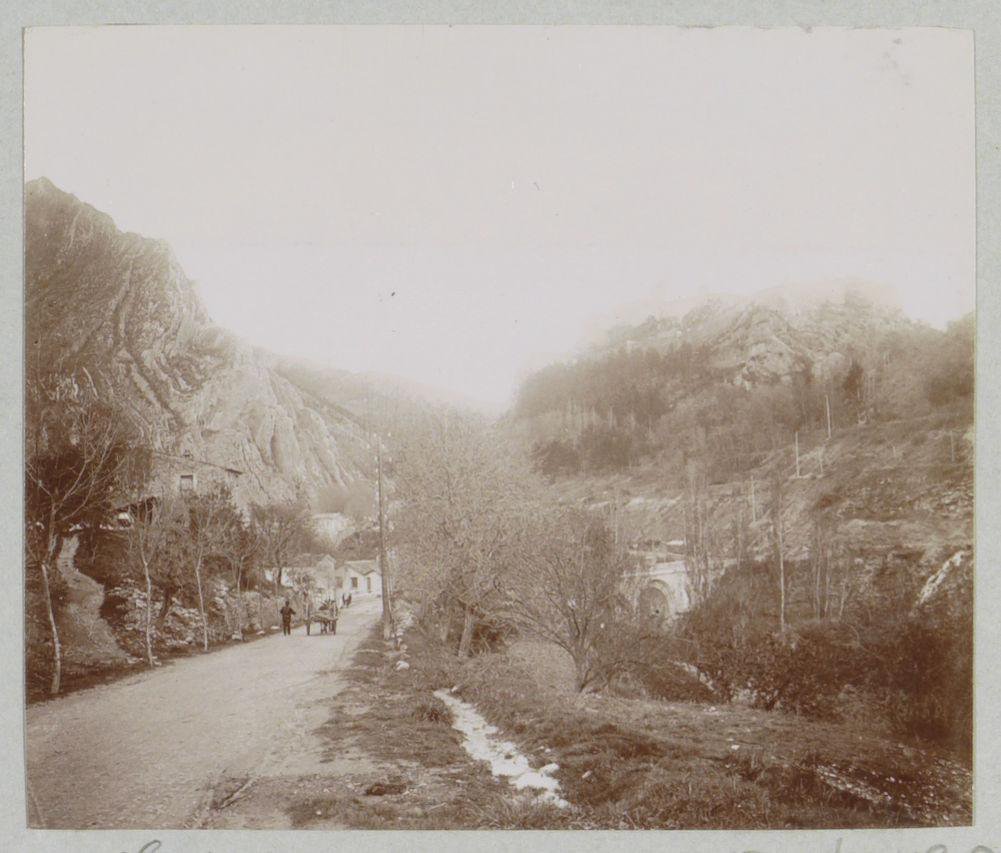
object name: photograph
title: Weg door een kloof bij Sisteron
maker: delizy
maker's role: manufacturer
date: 1903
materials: paper, photographic support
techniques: gelatin silver print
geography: sisteron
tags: ravine, chasm, abyss, canyon, road, path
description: Onderdeel van Fotoalbum van een Franse amateurfotograaf met opnames van uitstapjes in Frankrijk, Spanje, België, Luxemburg en Nederland, de eerste automobielen en autoraces.